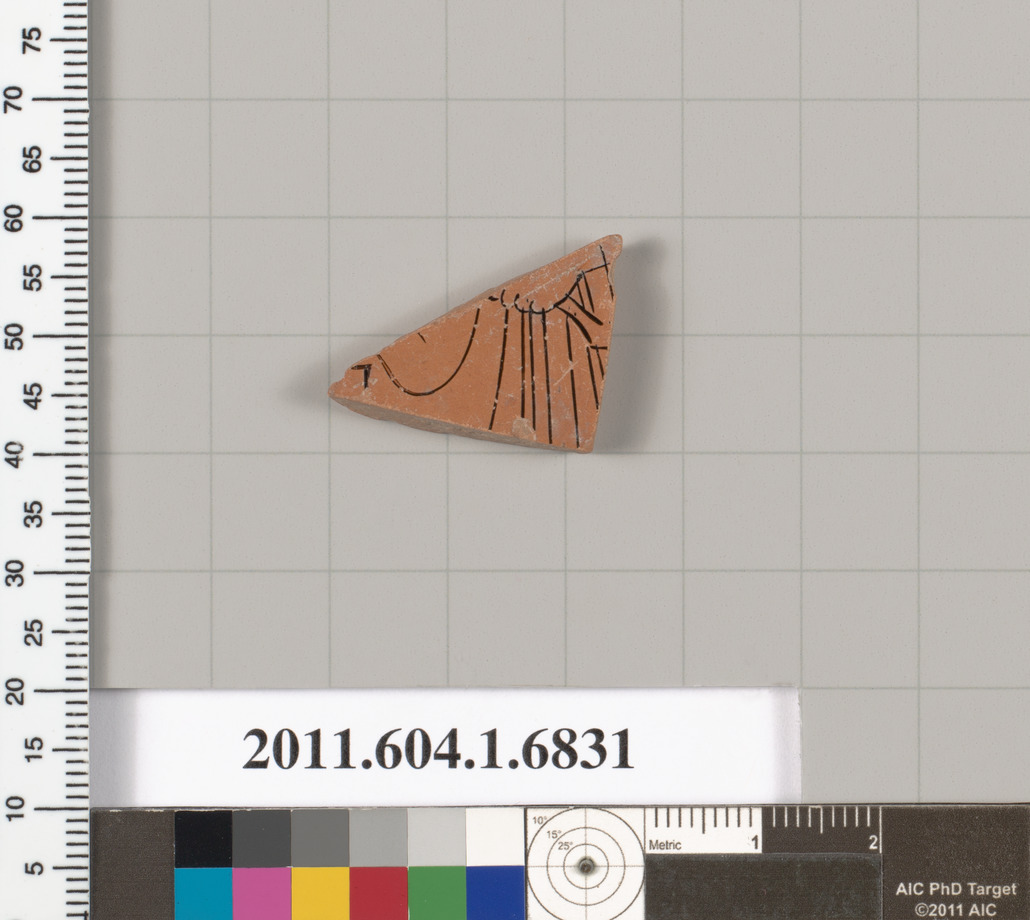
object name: kylix fragment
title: Terracotta fragment of a kylix (drinking cup)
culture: greek, attic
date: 490-470 BCE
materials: terracotta